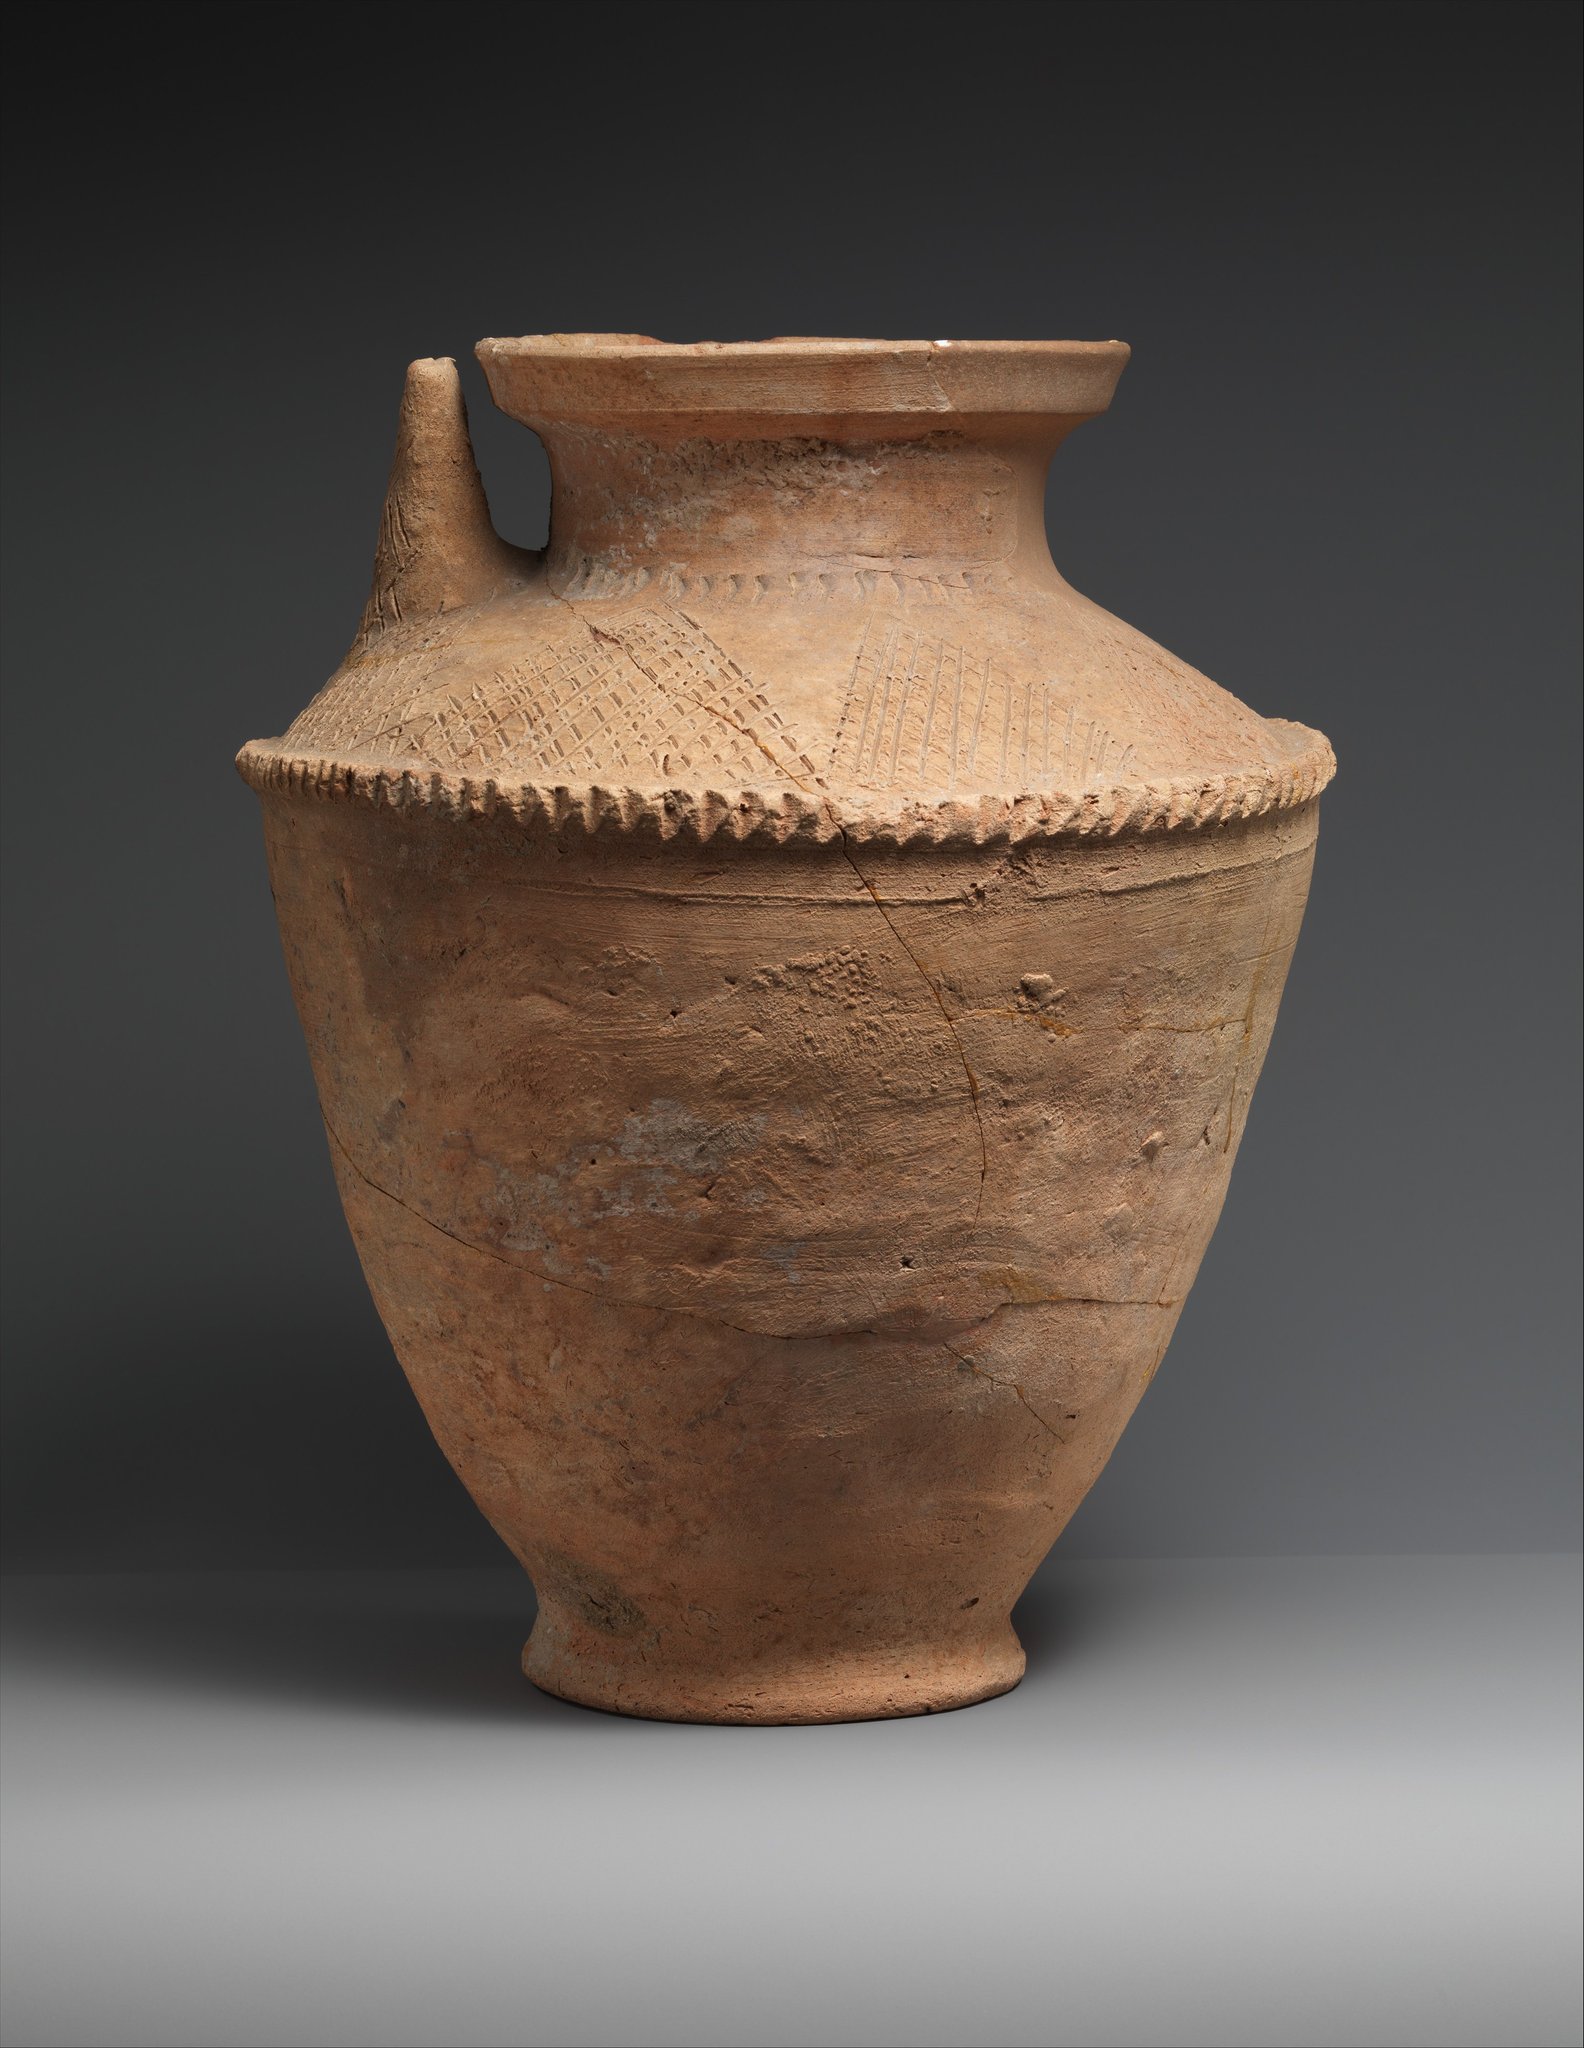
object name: vessel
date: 2700-2600 BCE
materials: ceramic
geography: mesopotamia, diyala region